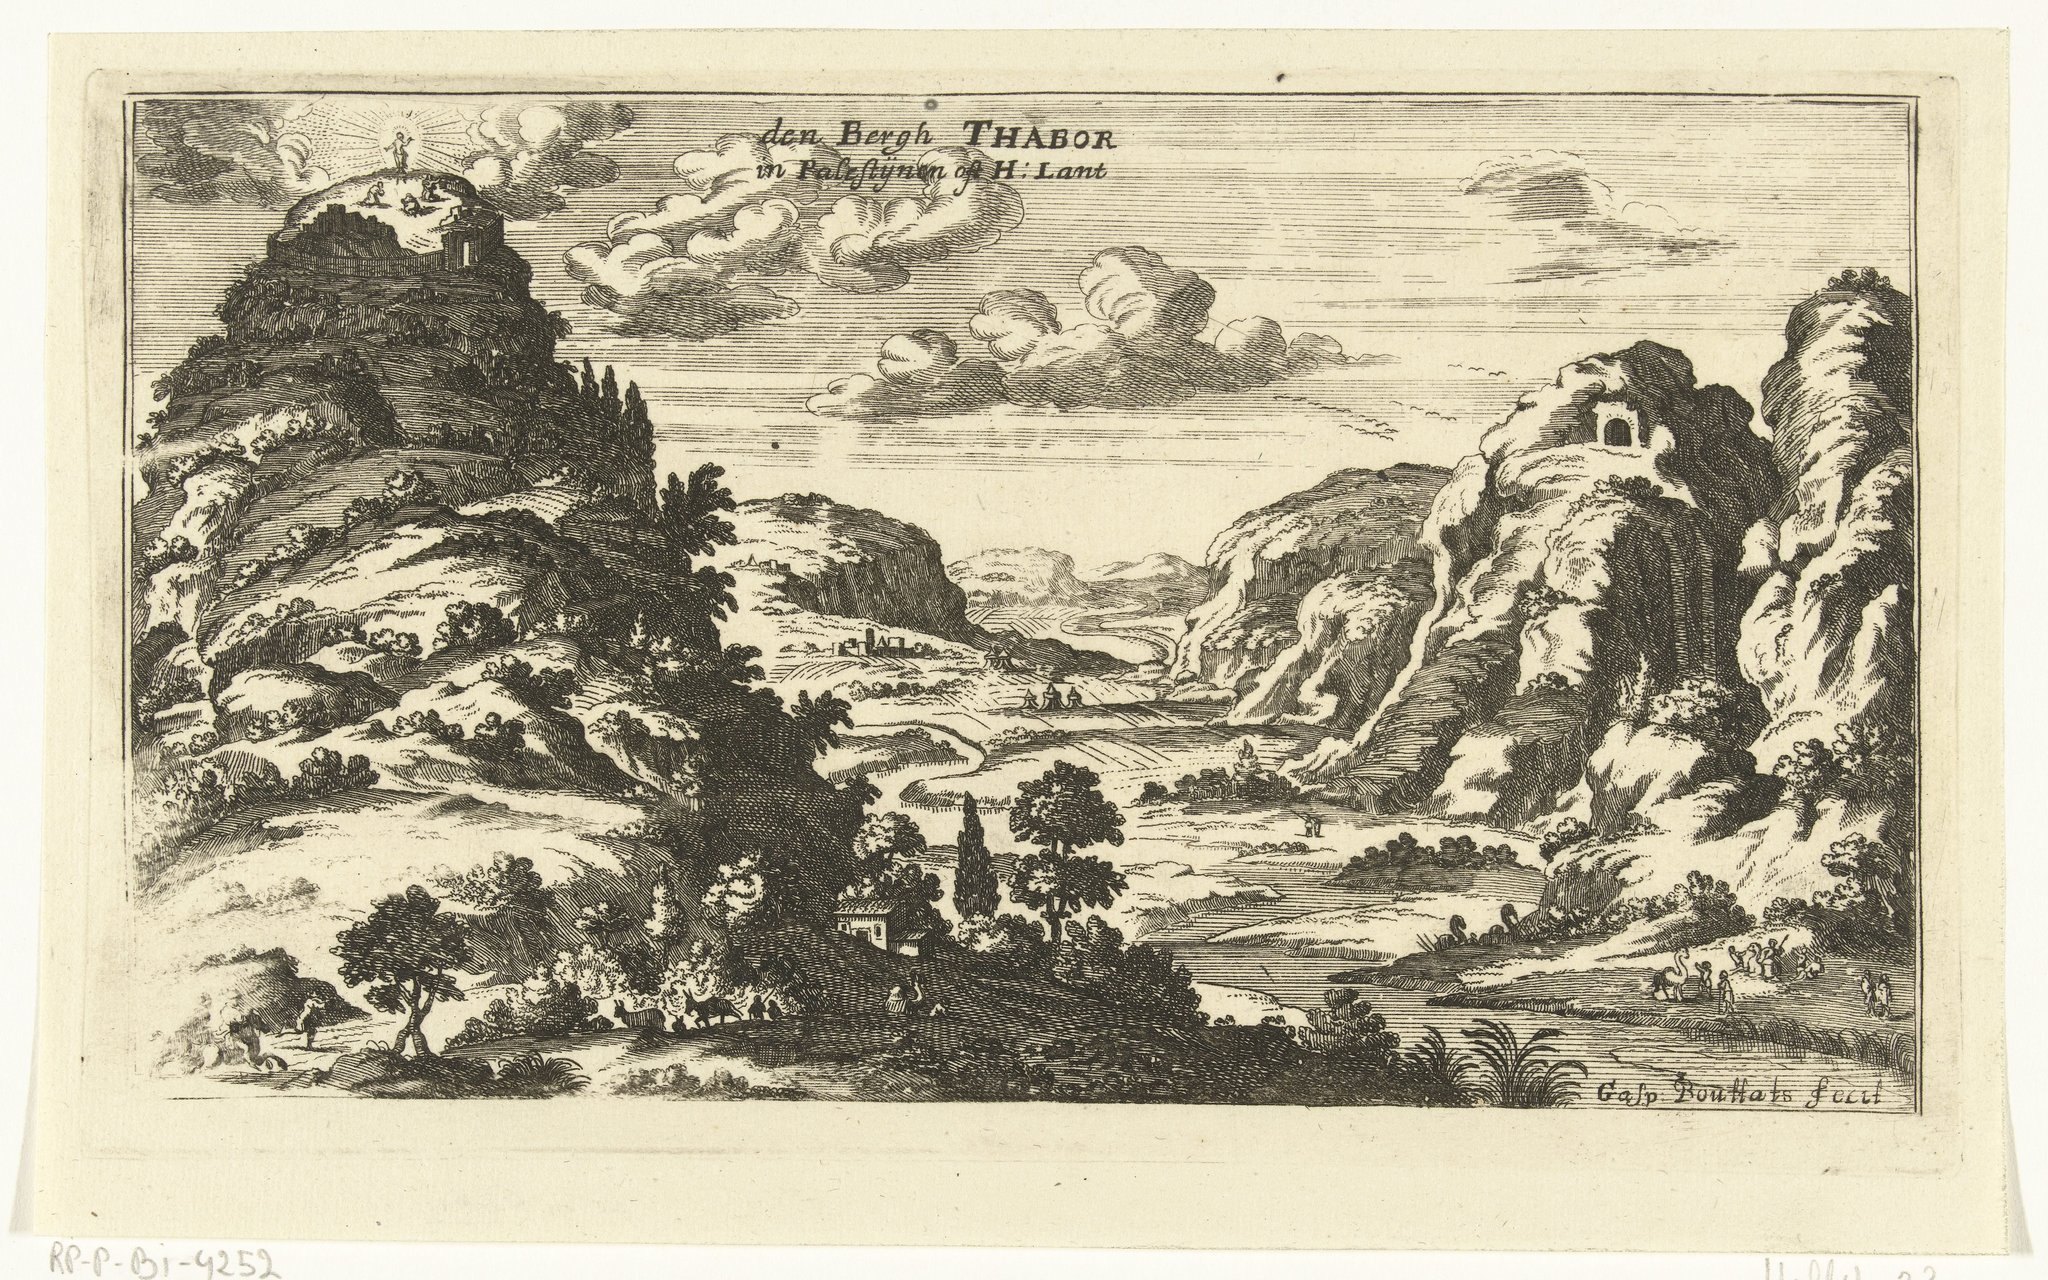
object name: print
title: Gezicht op de berg Tabor en de transfiguratie van Christus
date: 1672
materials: paper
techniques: etching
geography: antwerp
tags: the transfiguration: moses and elijah appear on either side of christ on mount tabor (matthew 17:1-13; mark 9:2-13; luke 9:28-36), (high) hill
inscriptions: collector's mark: Lugt 2228, caption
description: Gezicht op de berg Tabor links. Bovenop de berg de apostelen Petrus, Johannes en Jakobus die knielen voor Christus, wiens lichaam licht uitstraalt (Matteus 17:1-13). Rechts het dal rond de berg Tabor.